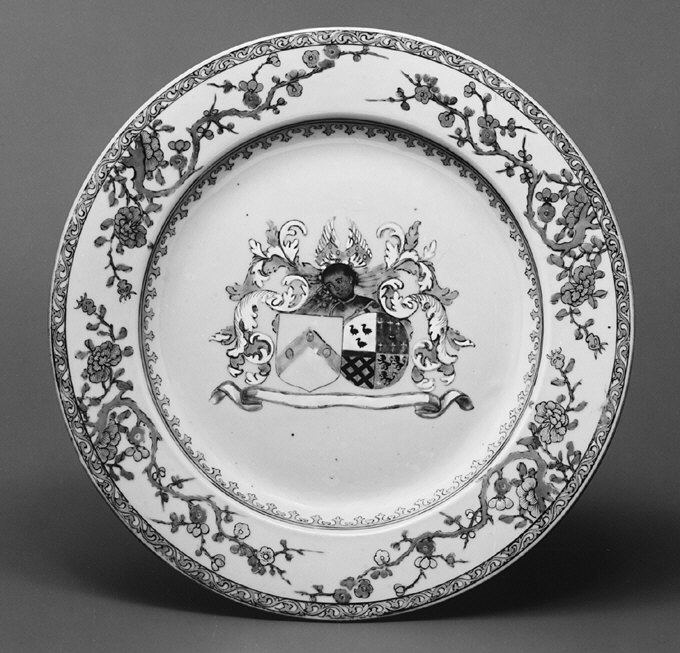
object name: plate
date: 1735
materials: hard paste porcelain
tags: flowers,coat of arms